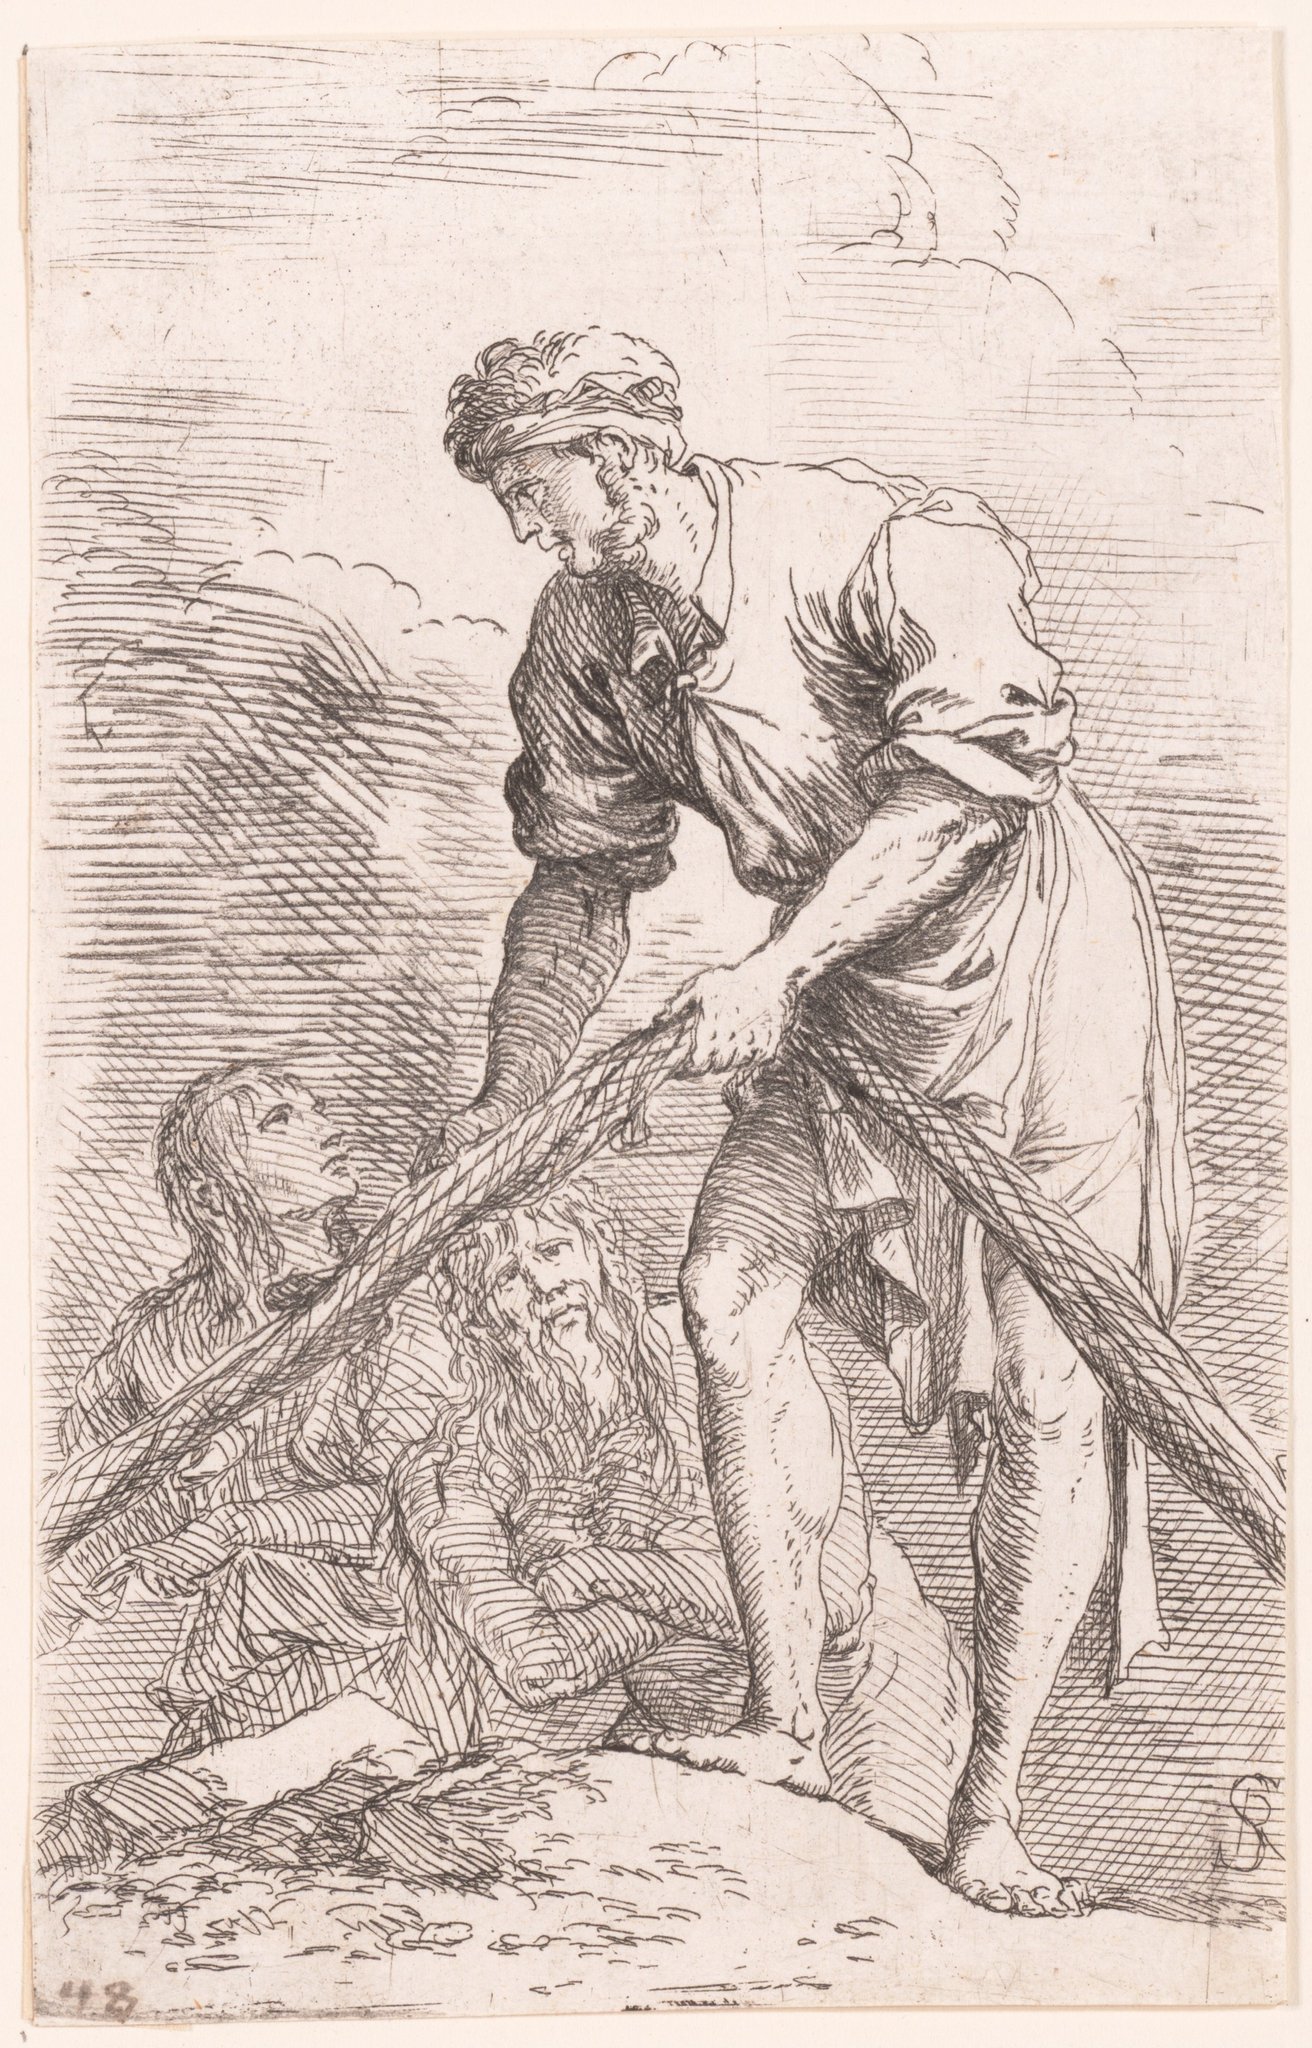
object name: print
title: A man pulling a net with two figures behind him, from "Figurine"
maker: salvator rosa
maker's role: artist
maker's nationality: italian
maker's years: 1615-1673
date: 1656-1657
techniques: drypoint, etching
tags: men,women,working